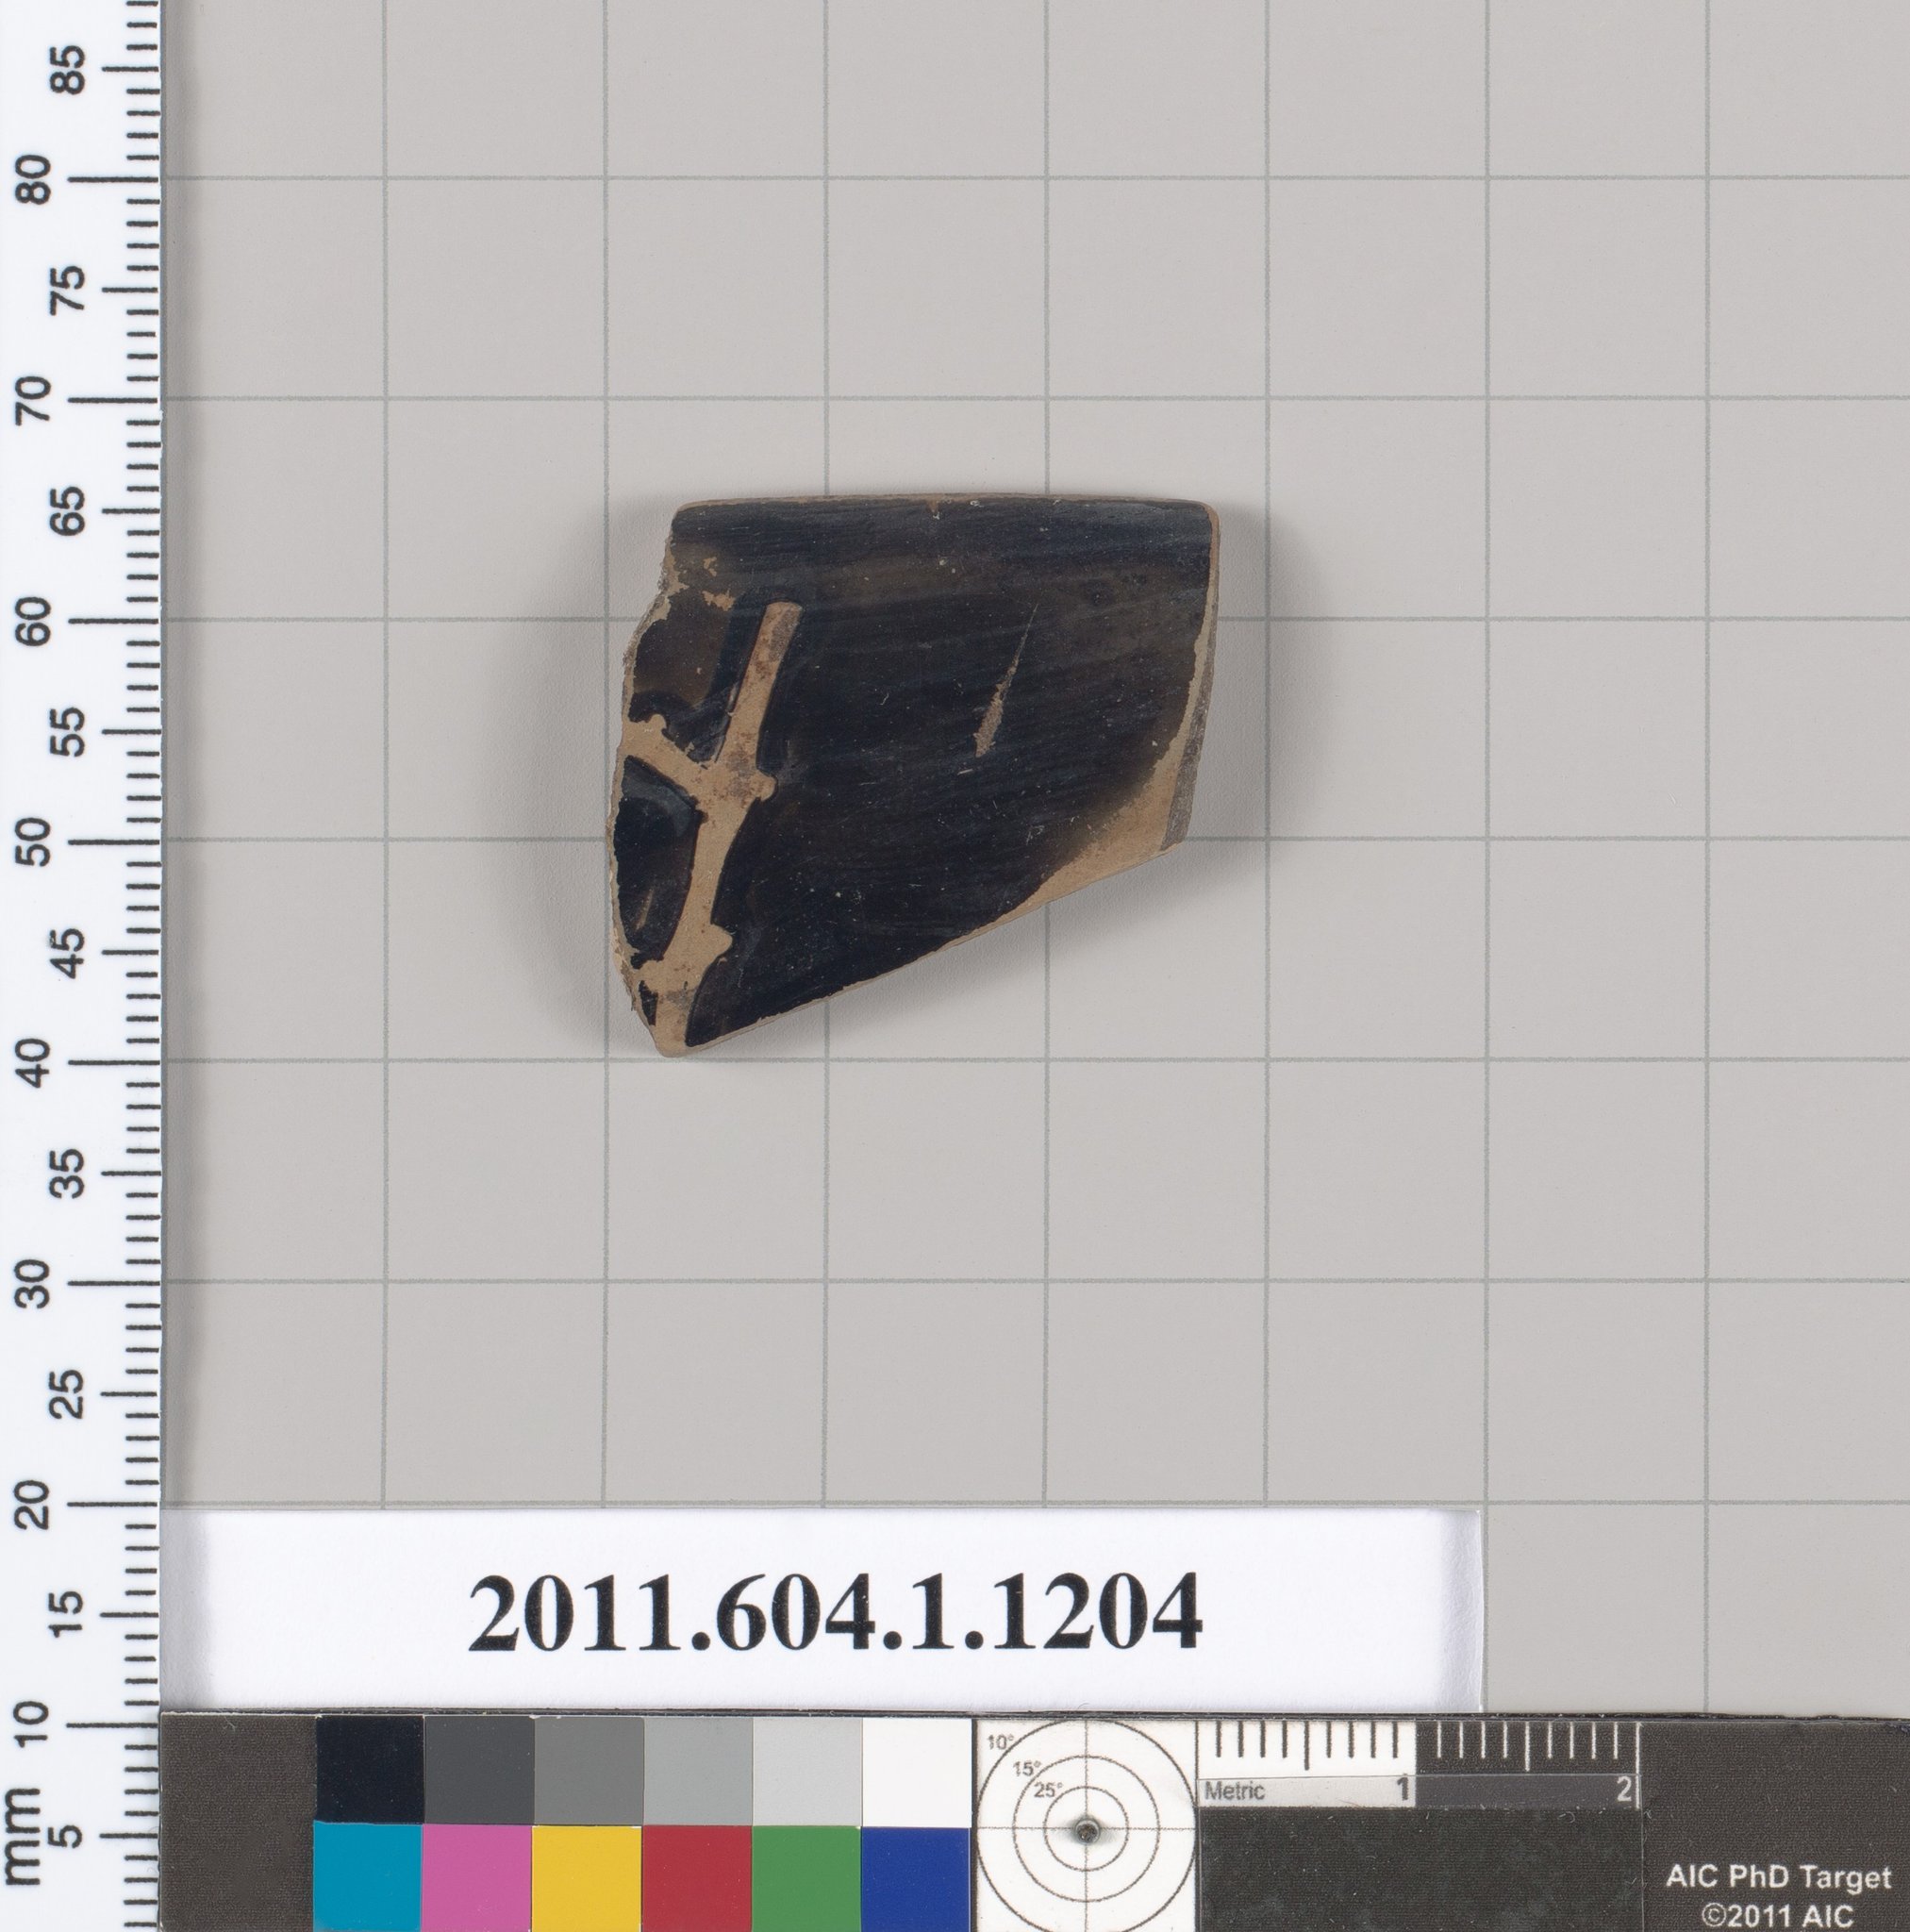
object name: kylix fragment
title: Terracotta rim fragment of a kylix (drinking cup)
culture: greek, attic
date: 490-480 BCE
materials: terracotta